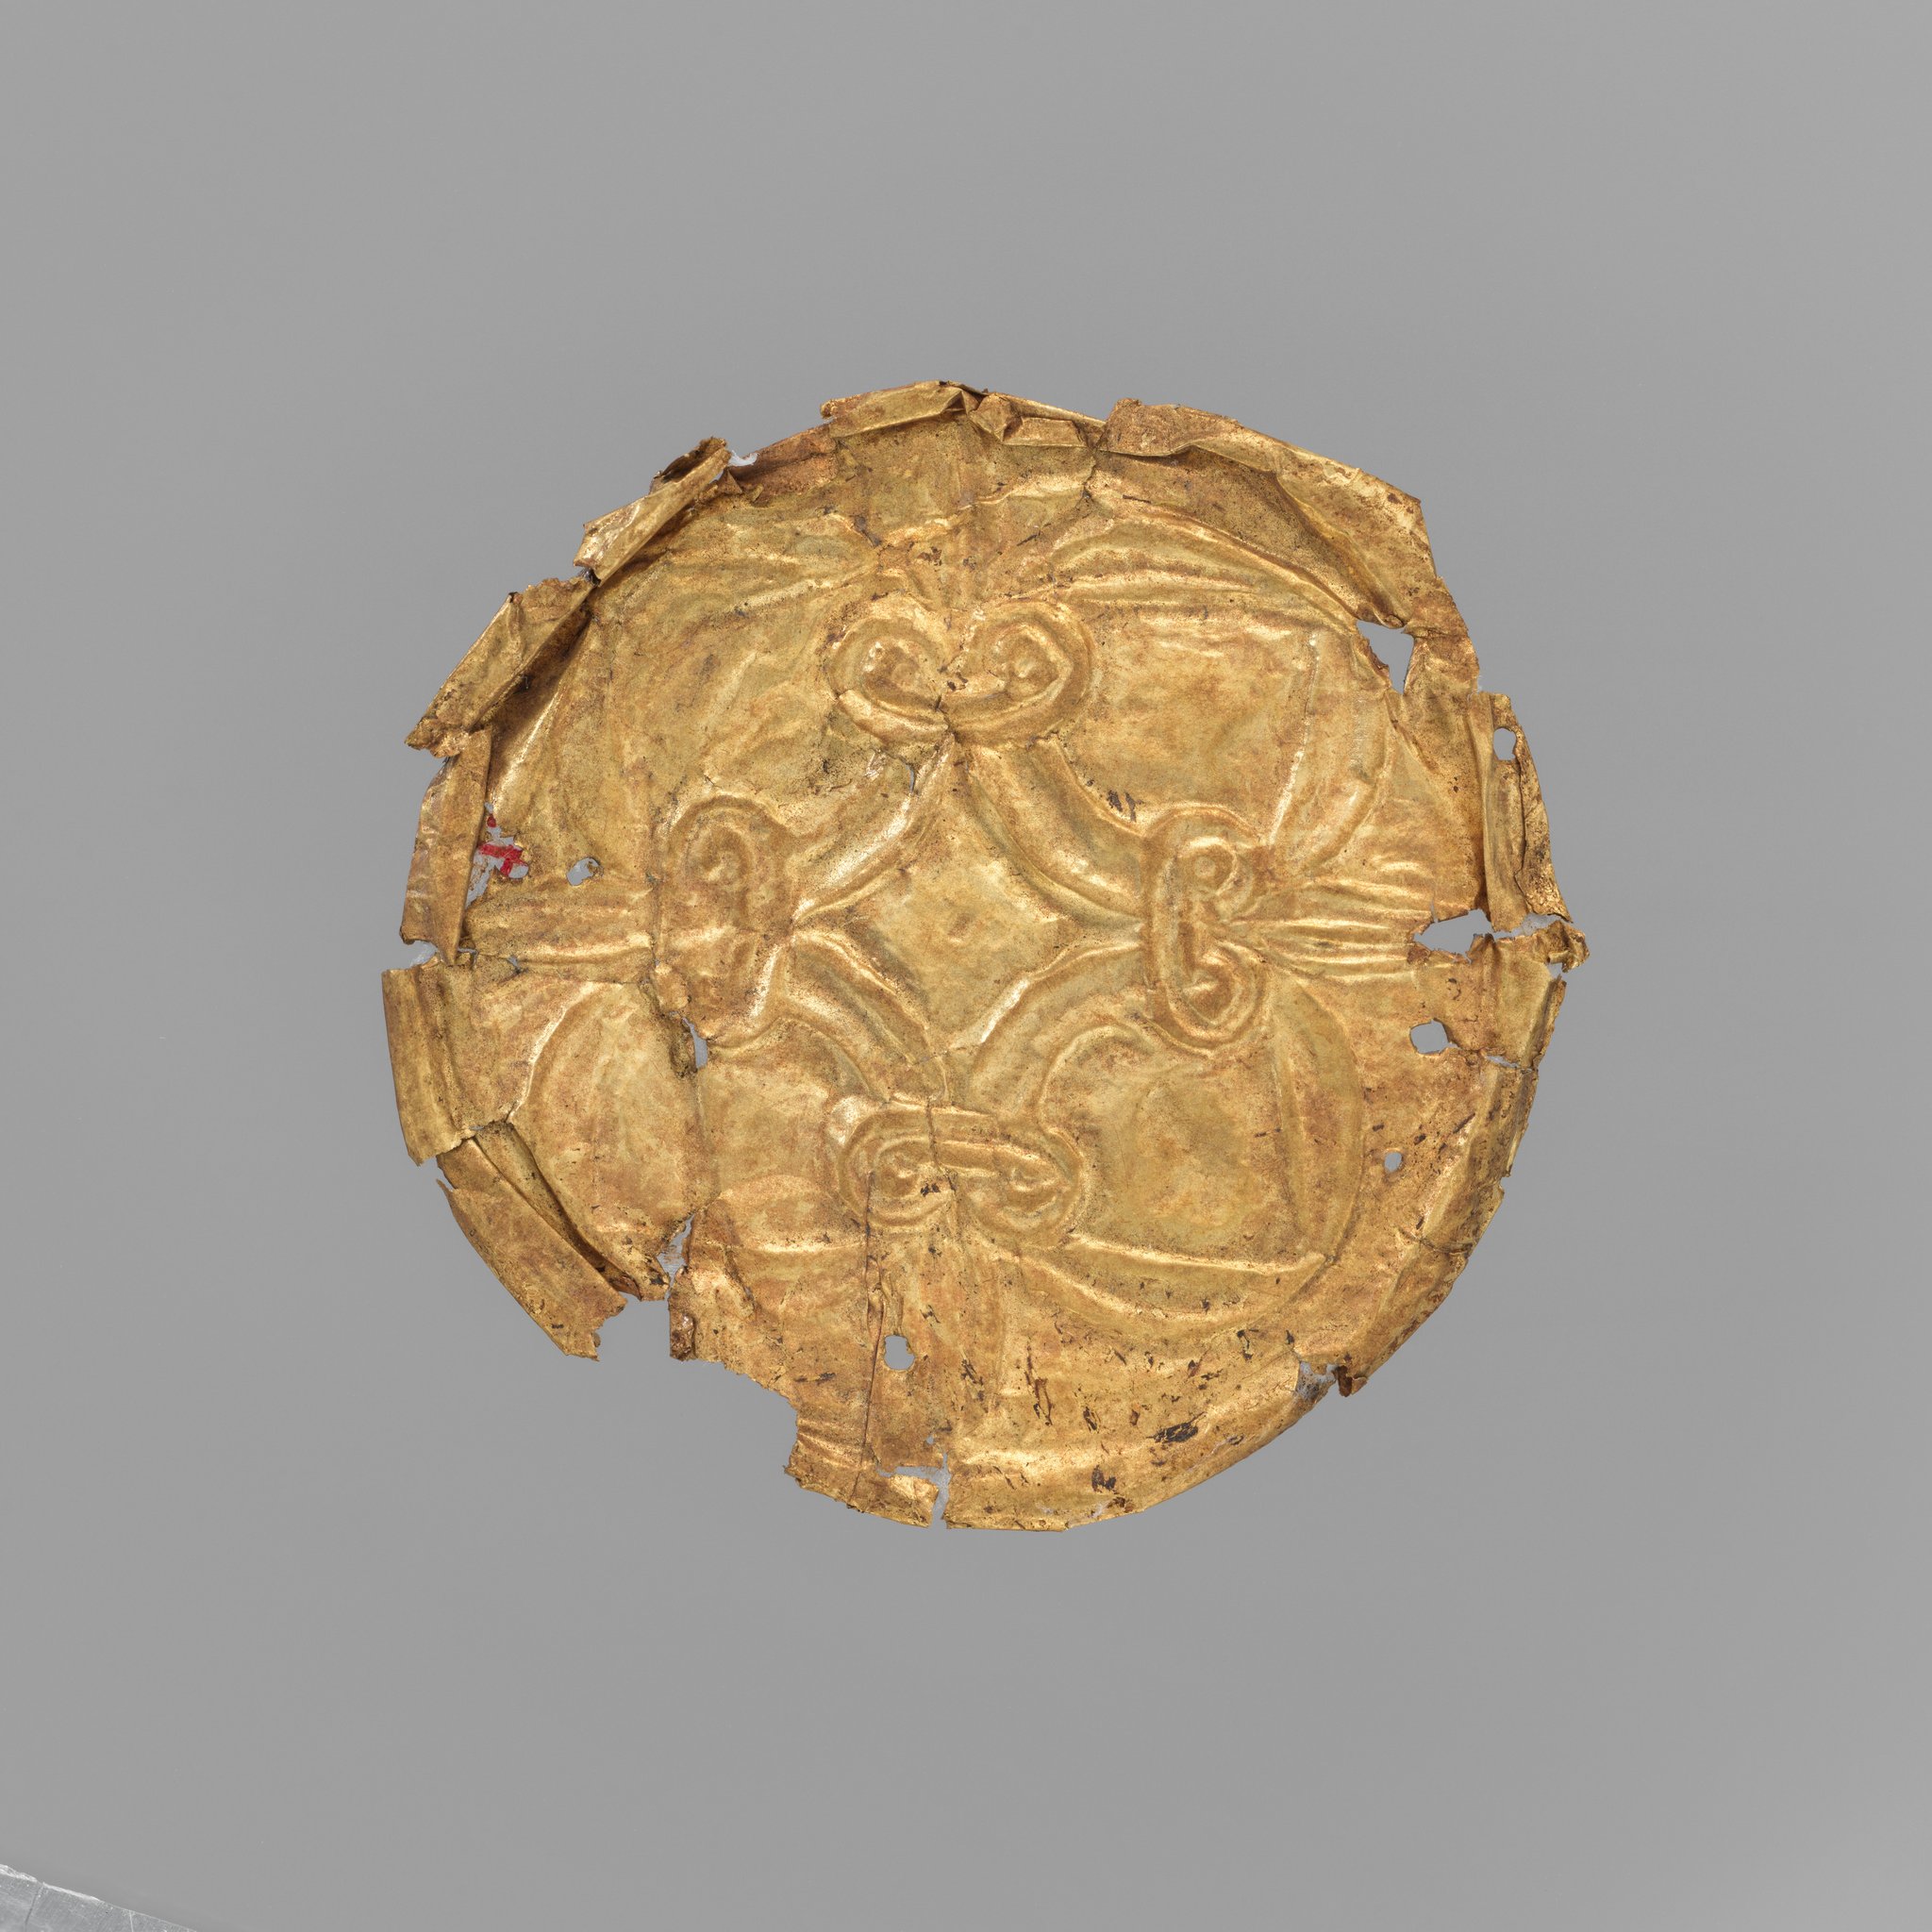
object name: roundel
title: Gold roundel with stamped designs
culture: cypriot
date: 1600-1050 BCE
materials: gold